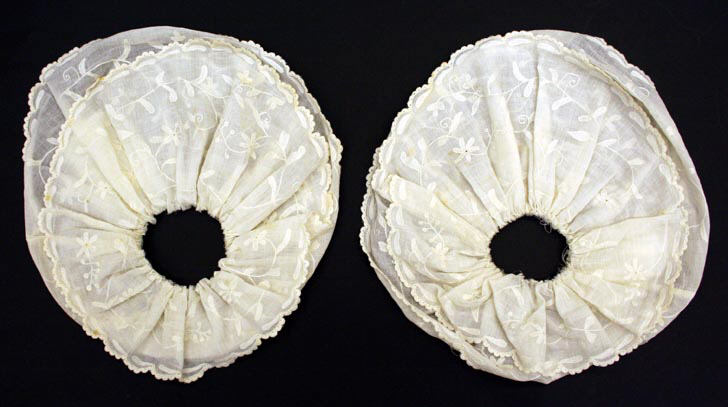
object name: engageantes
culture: british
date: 1770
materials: cotton